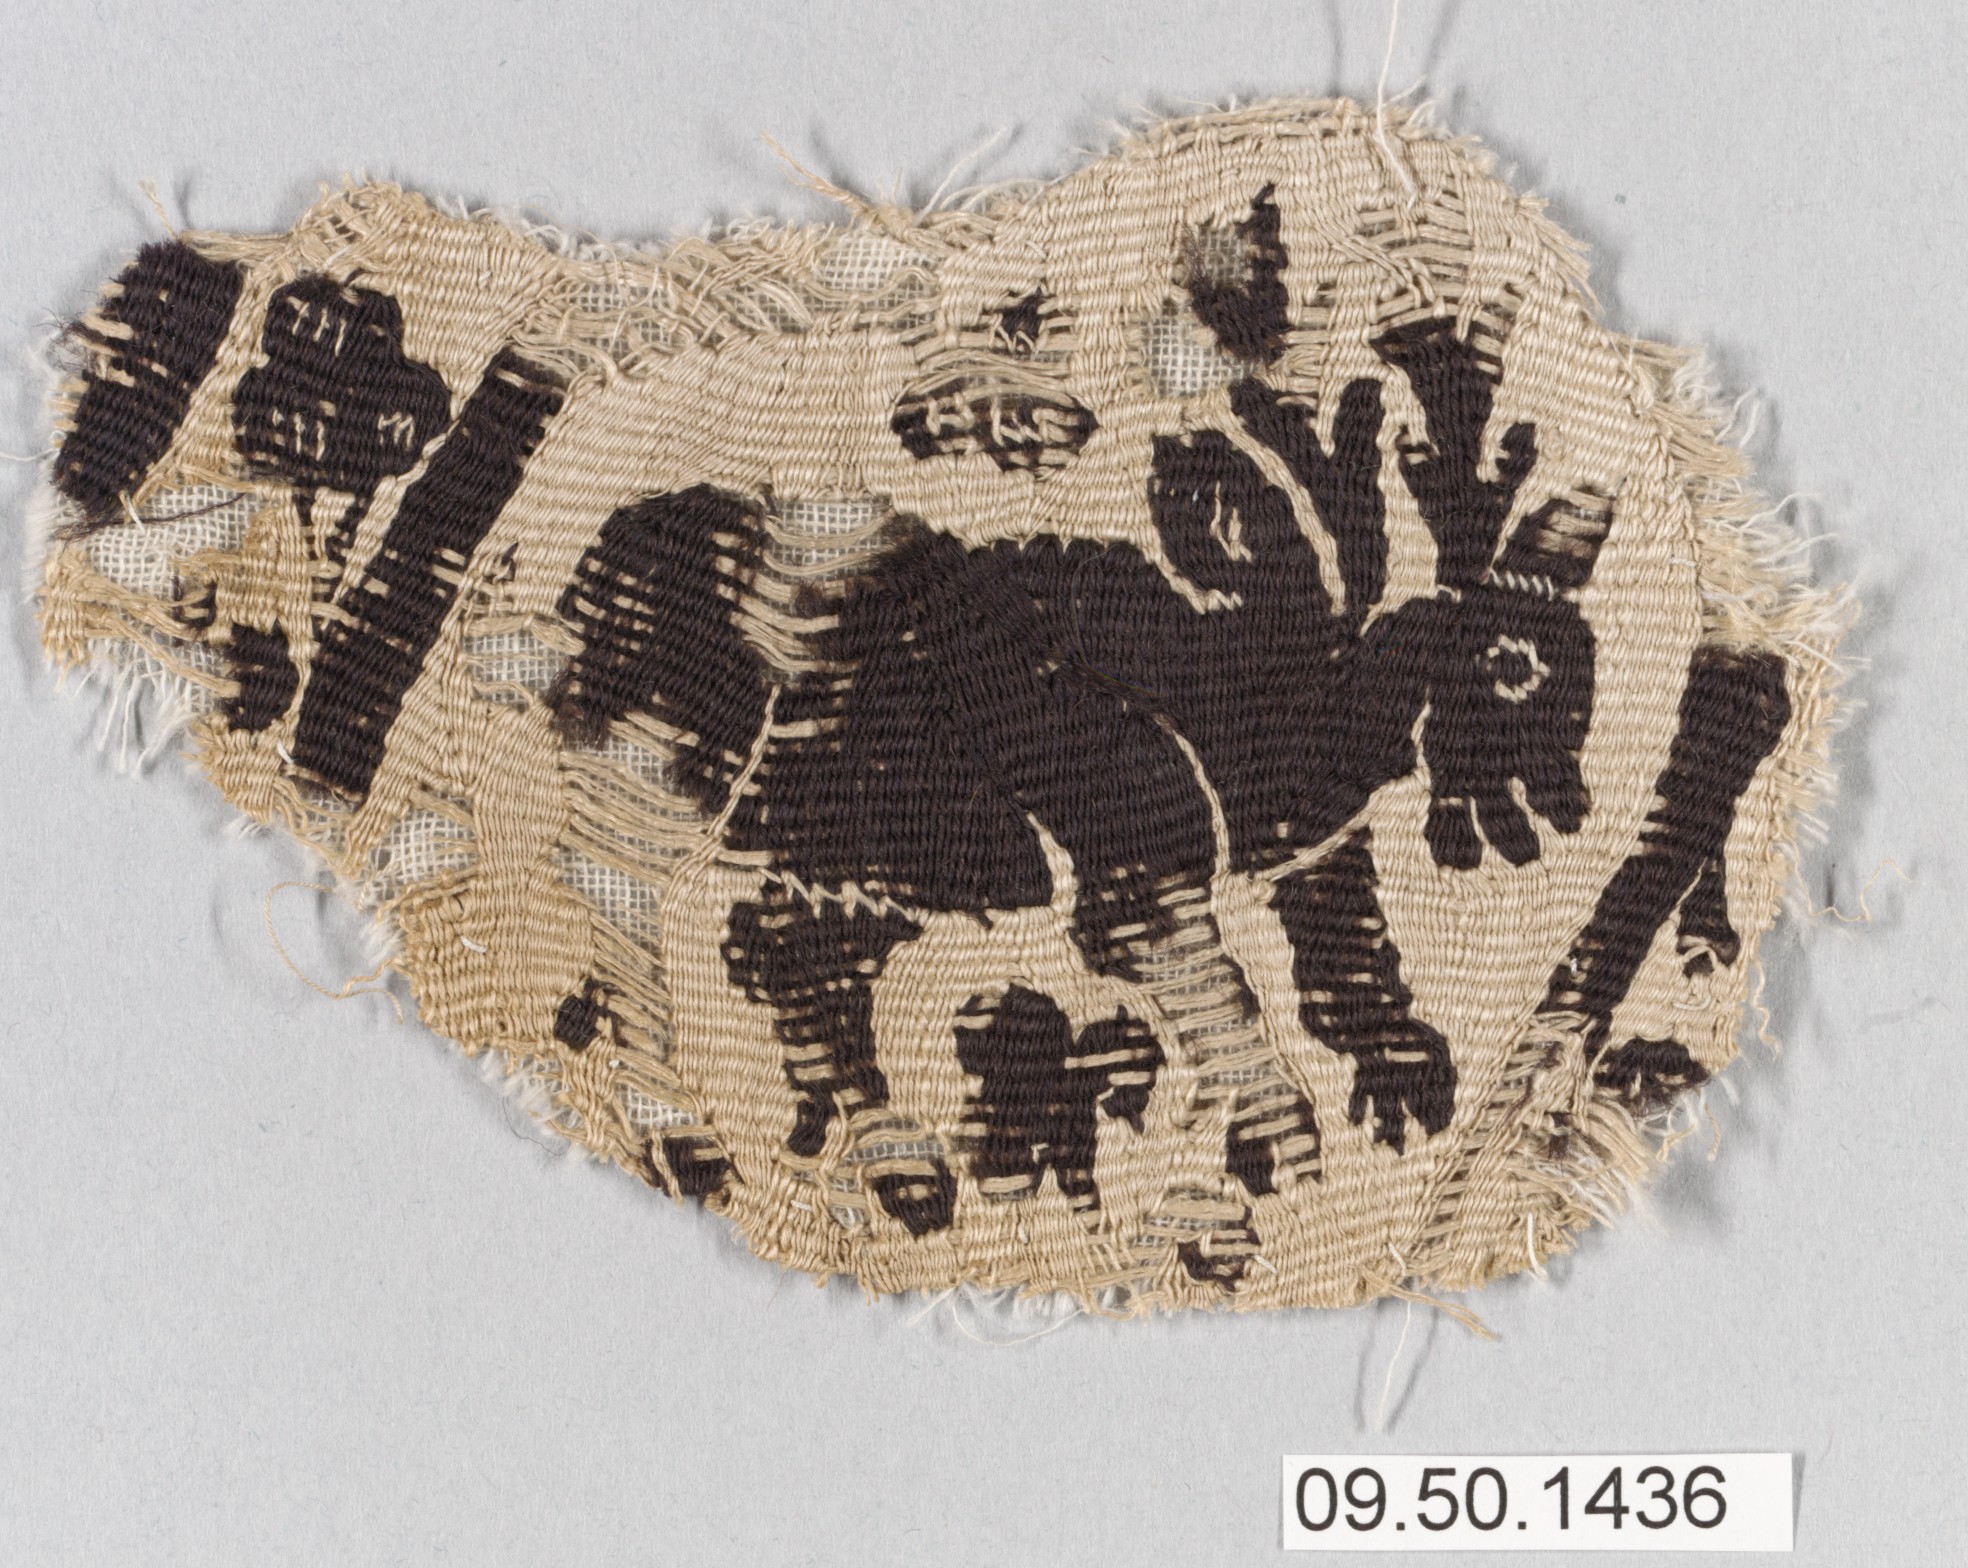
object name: textile fragment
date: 301-500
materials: linen, wool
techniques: weave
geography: egypt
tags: animals